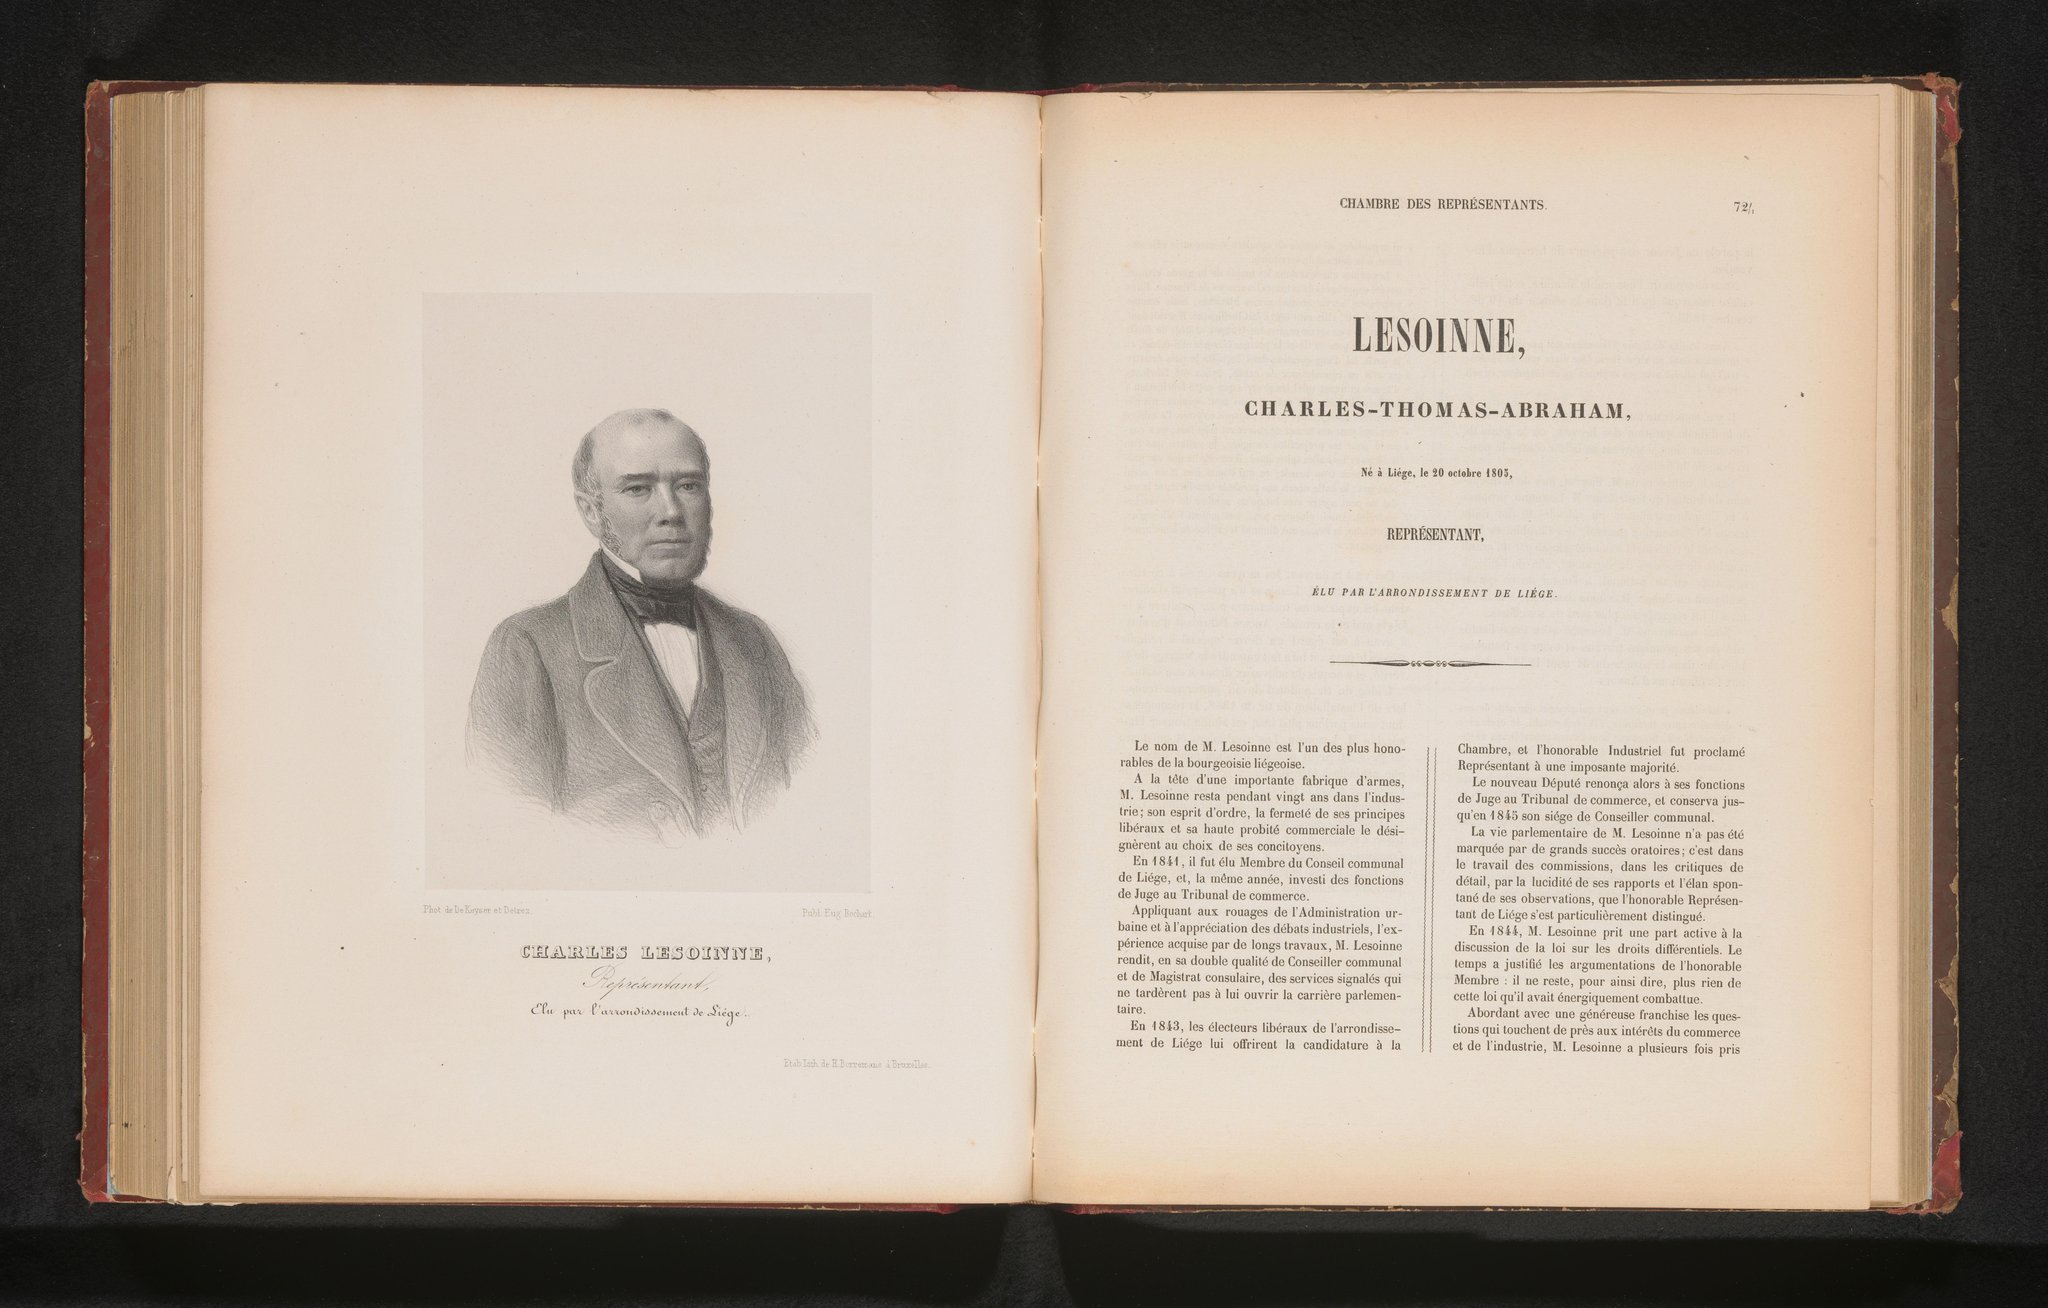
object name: page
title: Reproductie van een foto van een portret van Charles Lesoinne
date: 1853-1858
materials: paper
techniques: lithograph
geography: brussels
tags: politician, historical persons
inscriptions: inscription: ‘Représentant,/ Elu par l'arrondissement de Liége.’